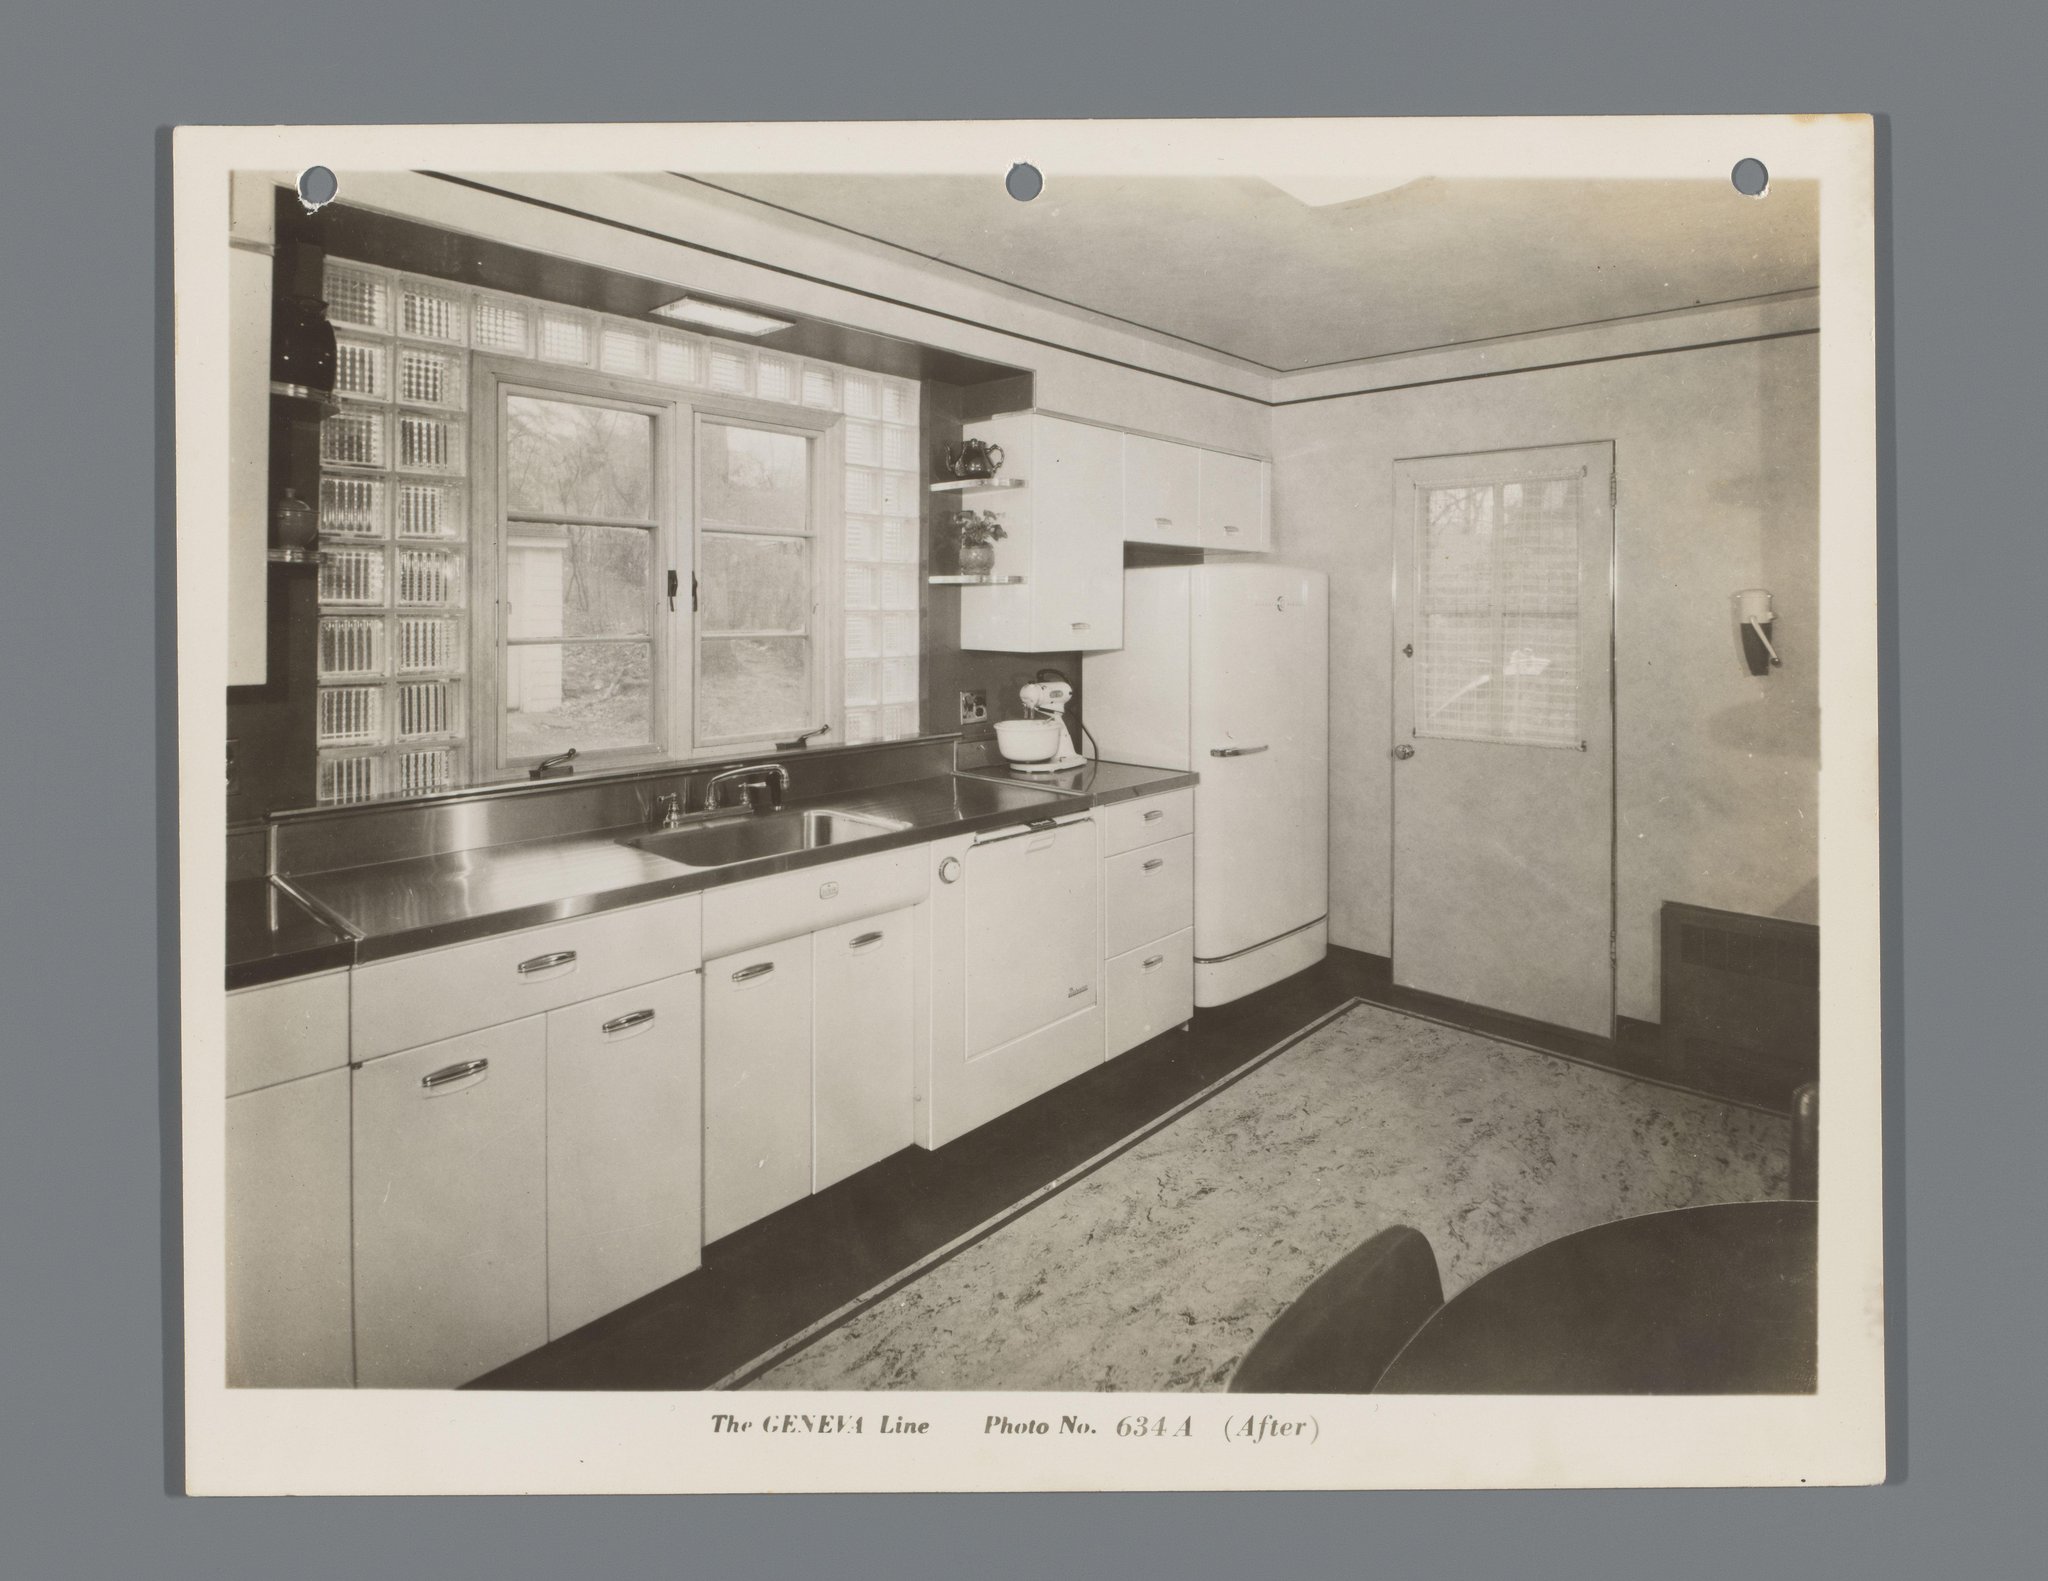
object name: photograph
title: Keuken Geneva Line, after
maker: Anonymous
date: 1920-1930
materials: photographic support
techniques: gelatin silver print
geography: united states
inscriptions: inscription: ‘The GENEVA Line Photo No. 634 A (After)’